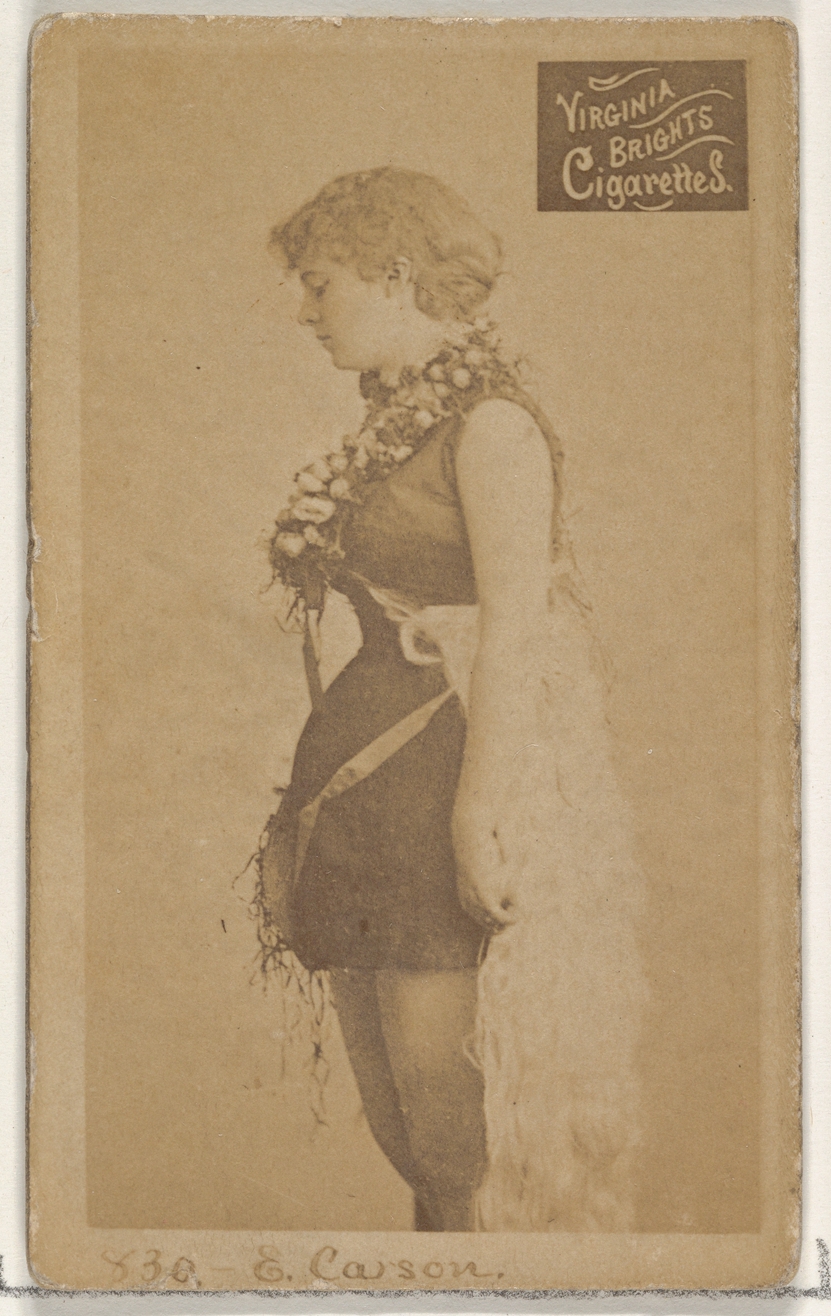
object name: photograph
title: Card 830, Emma Carson, from the Actors and Actresses series (N45, Type 2) for Virginia Brights Cigarettes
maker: allen & ginter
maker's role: publisher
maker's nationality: american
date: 1888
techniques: albumen silver print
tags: portraits,women,actresses